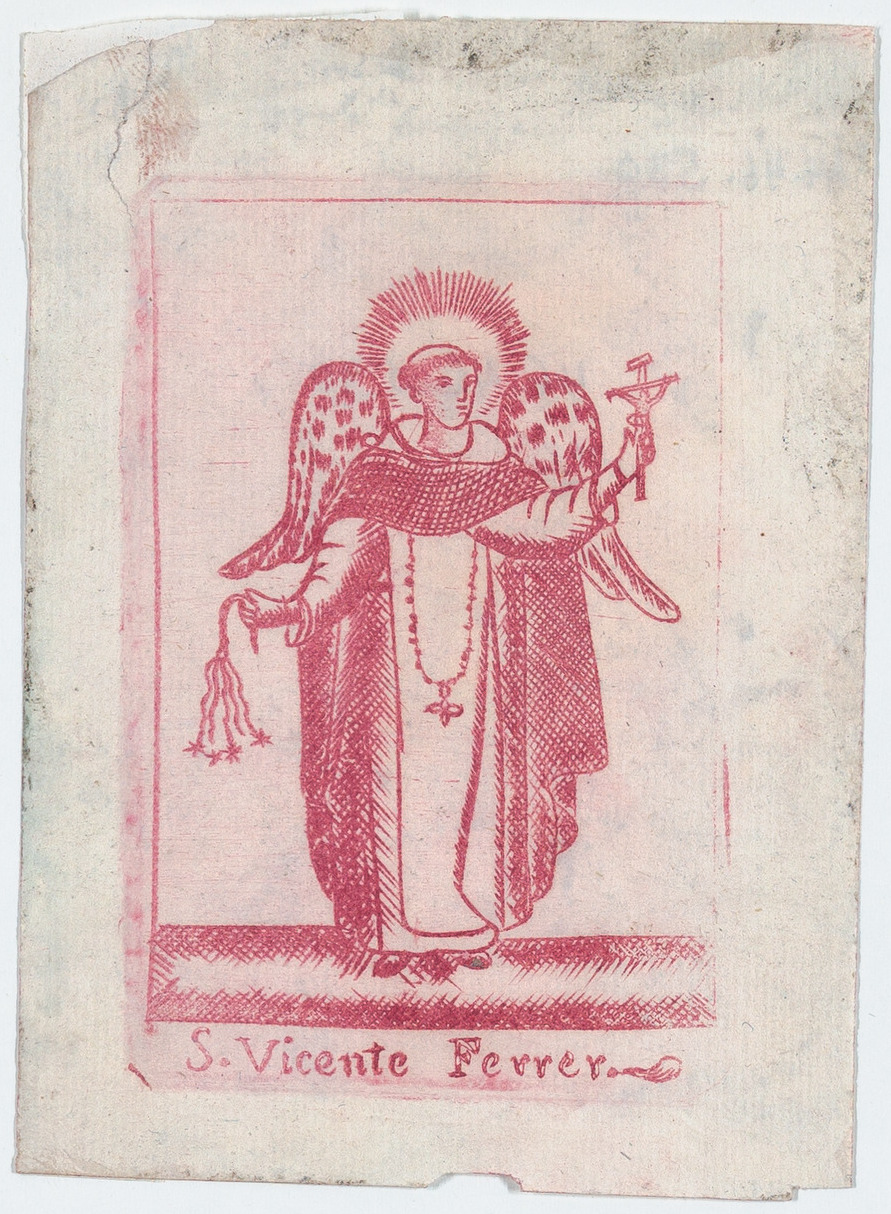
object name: print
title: Saint Vincente Ferrer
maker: anonymous, mexican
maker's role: artist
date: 1801-1900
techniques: engraving, printing